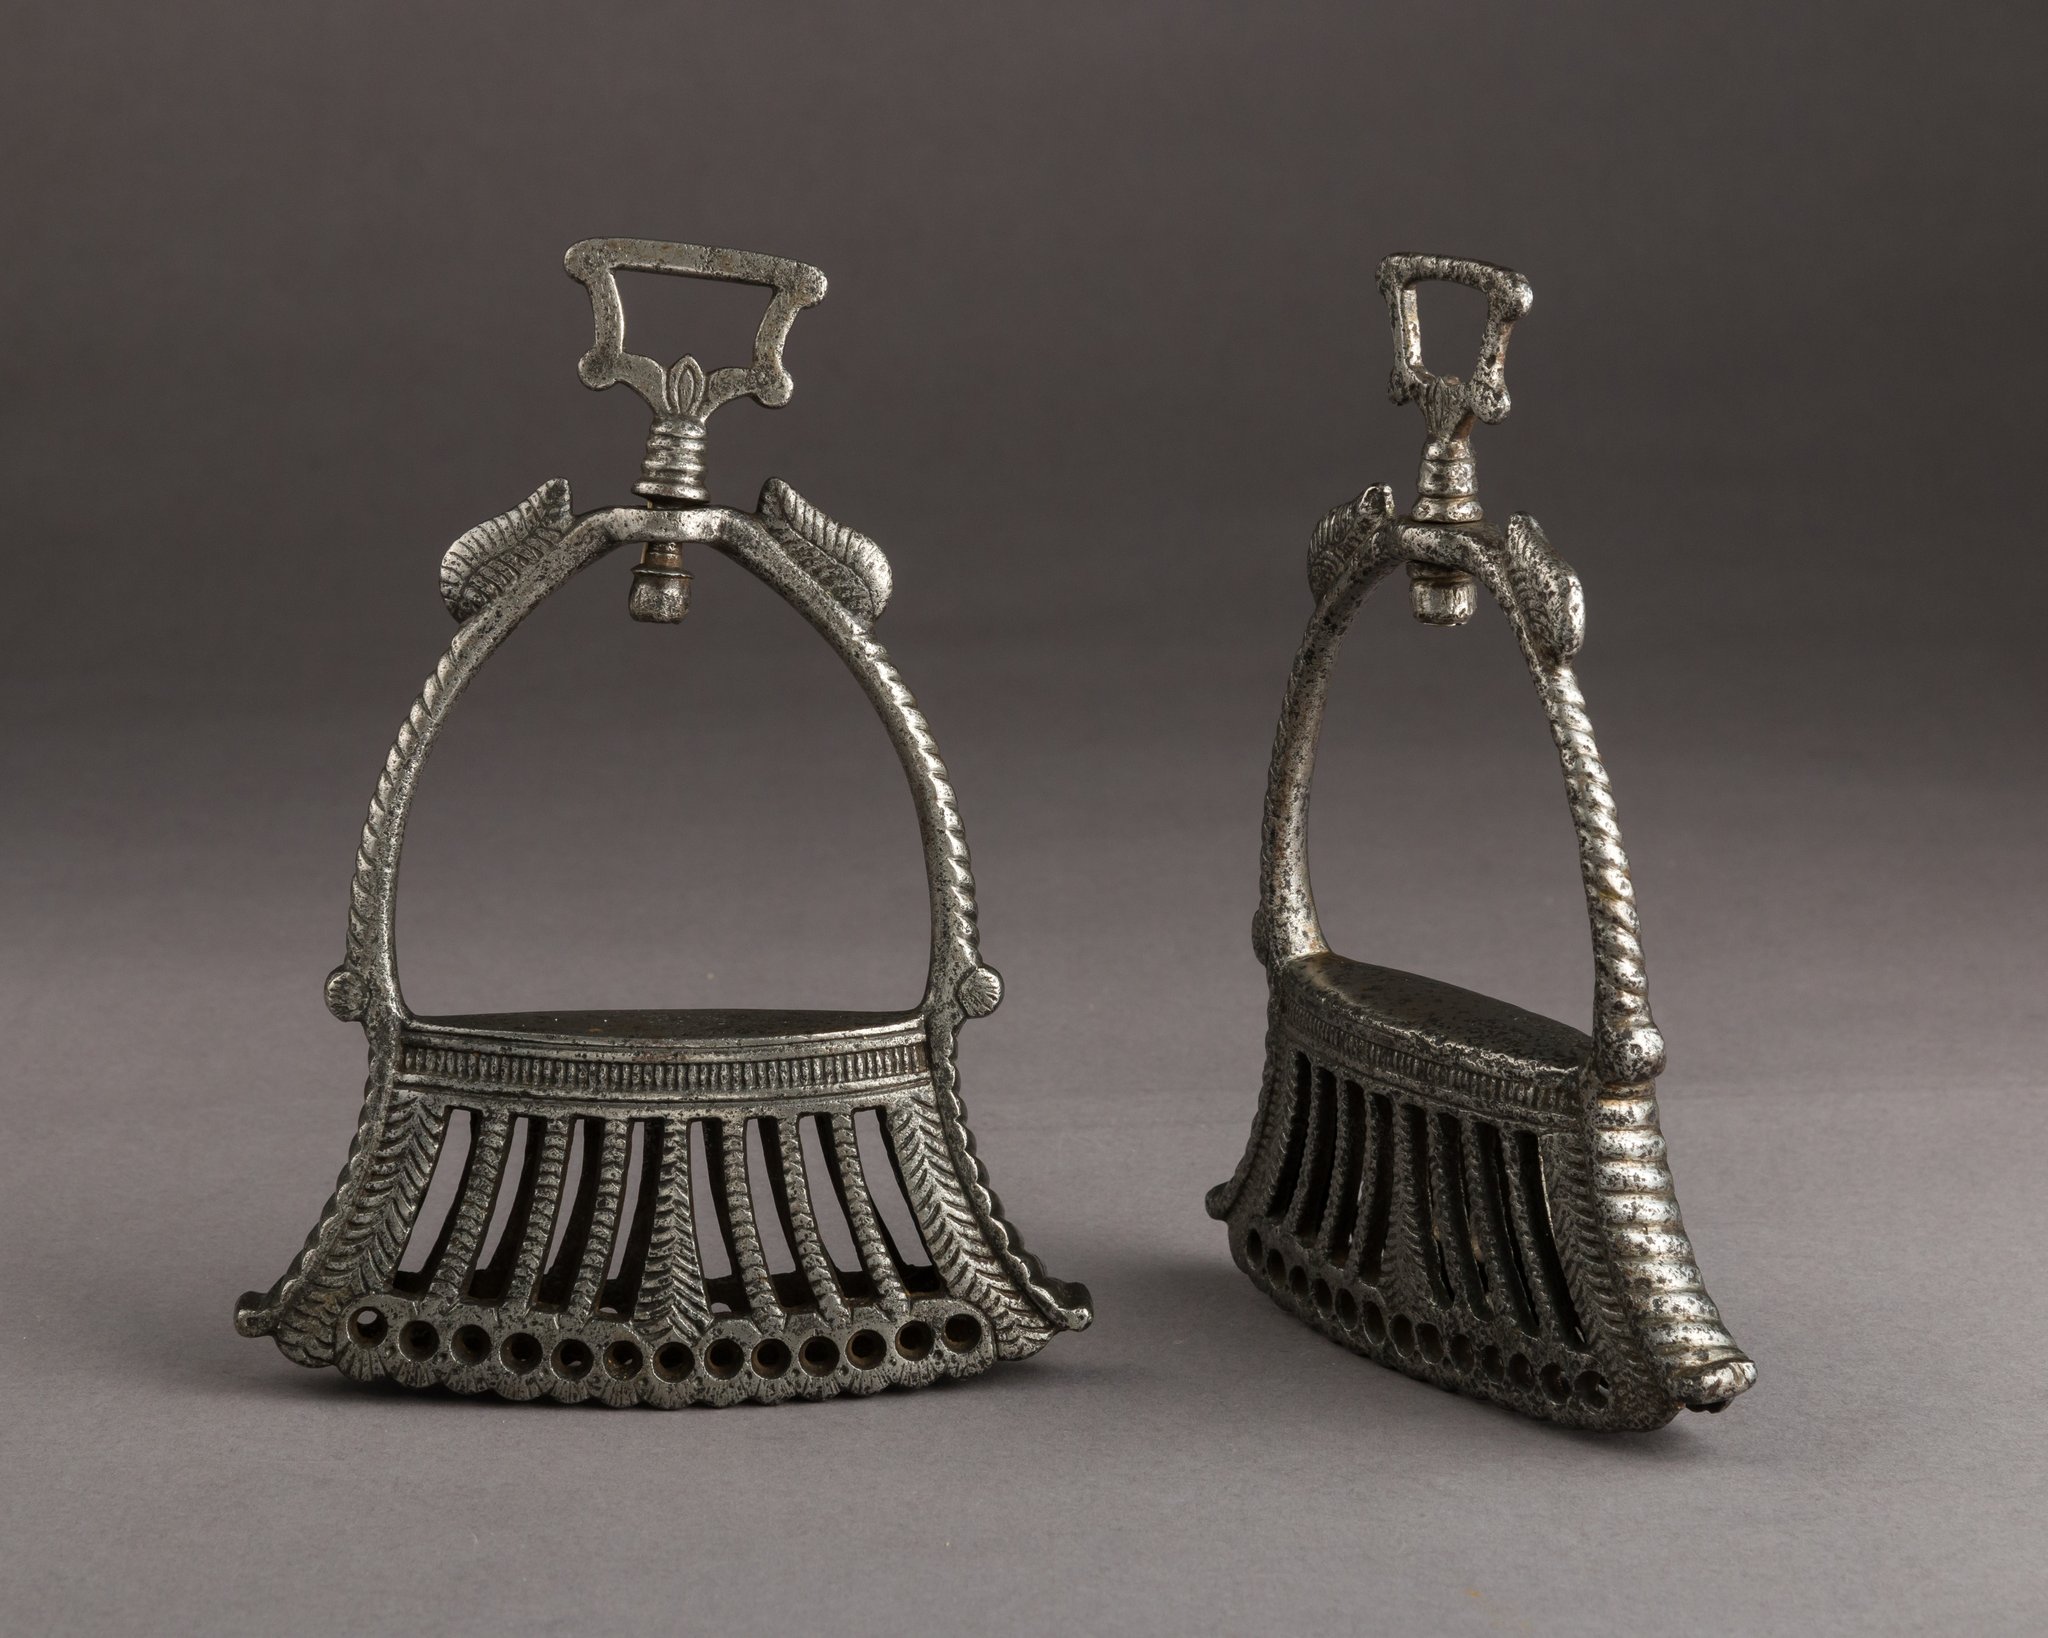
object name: stirrup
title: Pair of Stirrups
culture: argentinian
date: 1801-1900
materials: metal alloy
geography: argentina